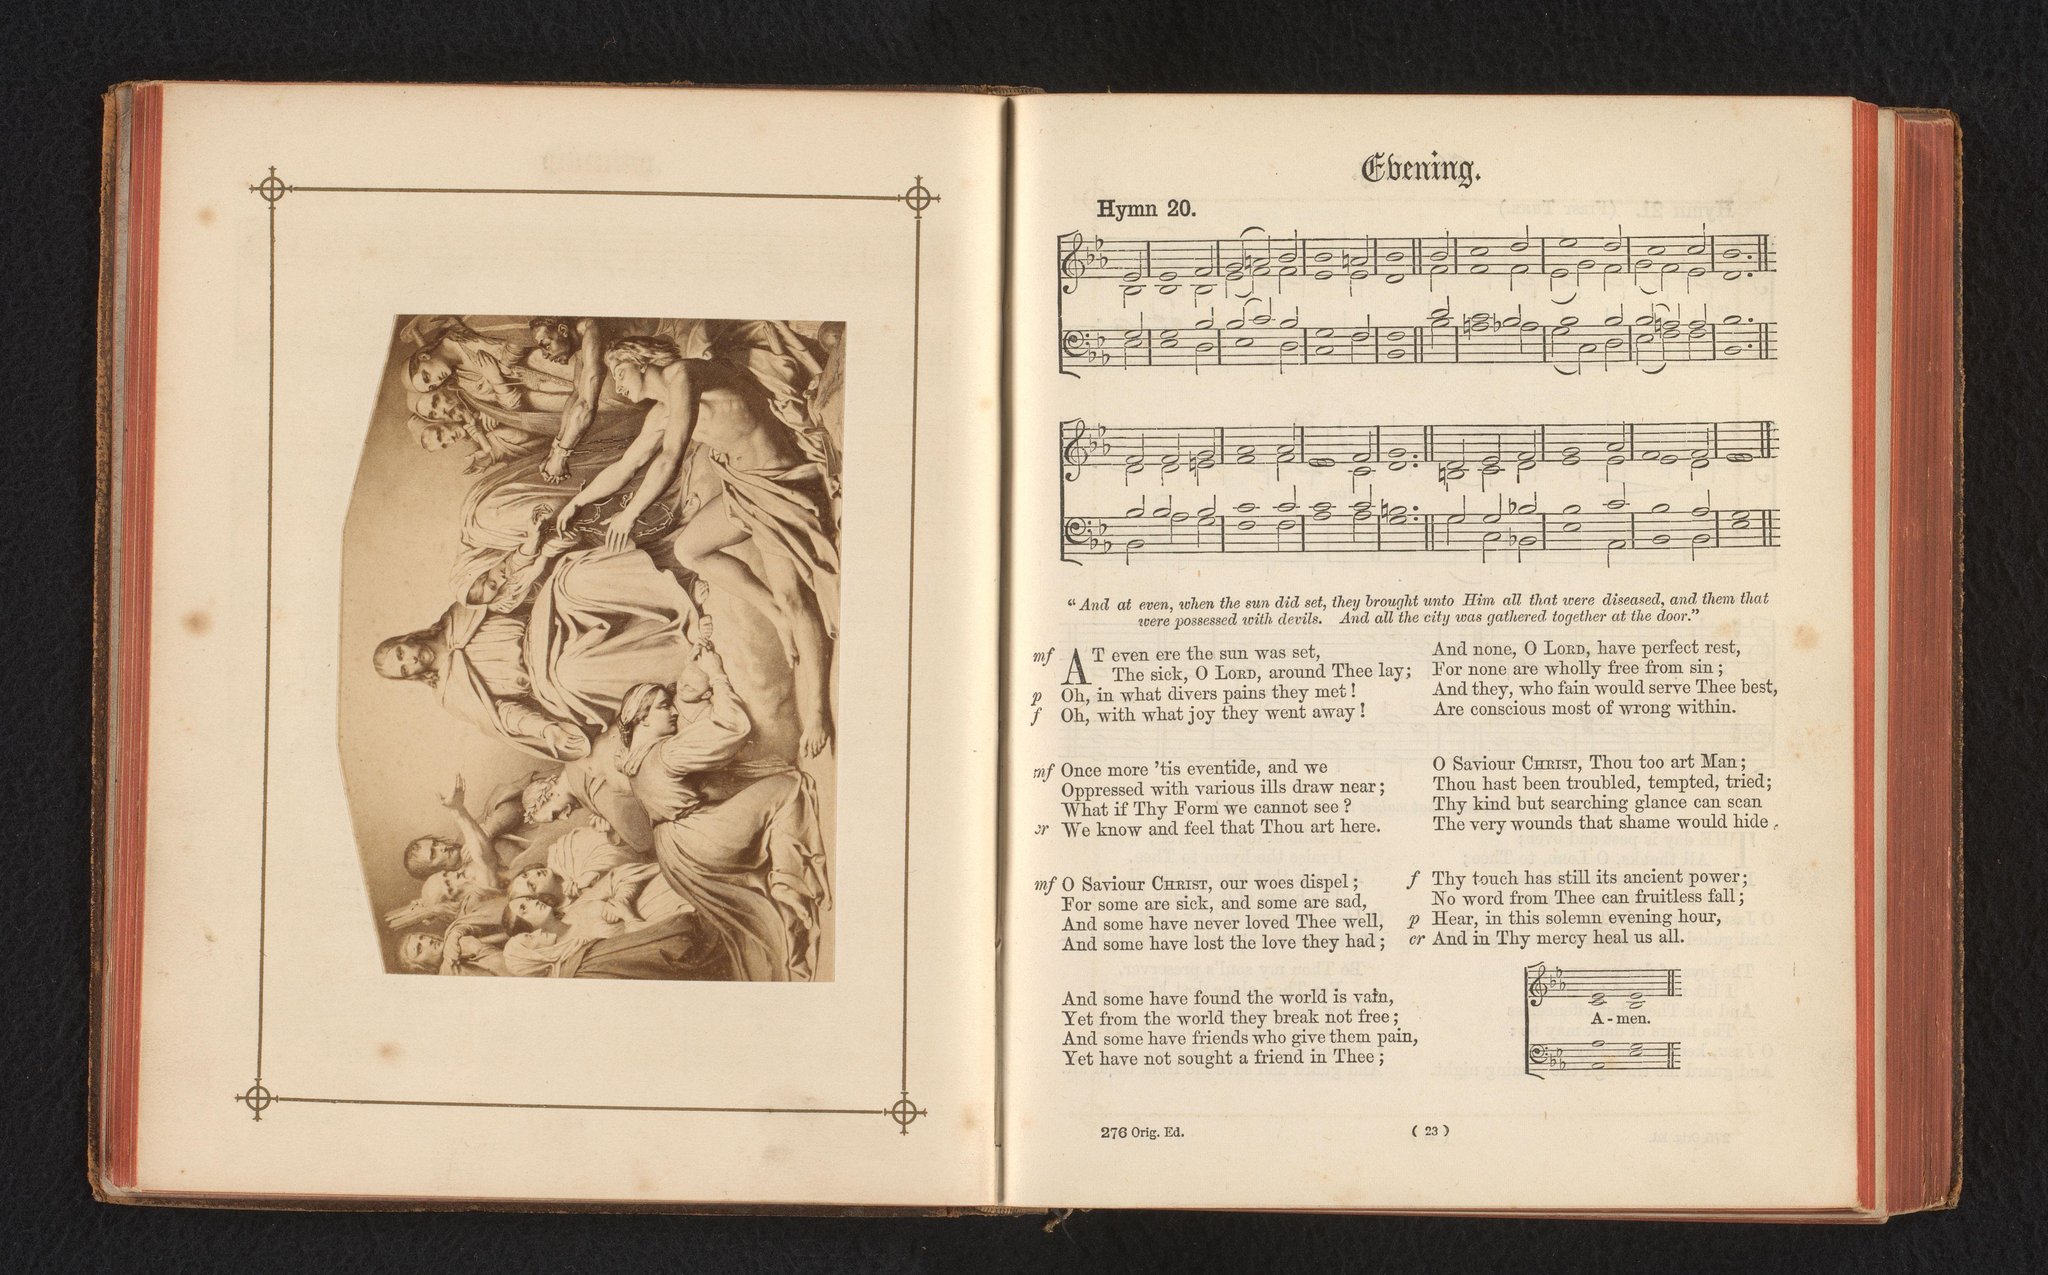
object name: page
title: Fotoreproductie van een schilderij van Christus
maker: Anonymous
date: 1867-1876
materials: paper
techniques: albumen print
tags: christ, picture, painting